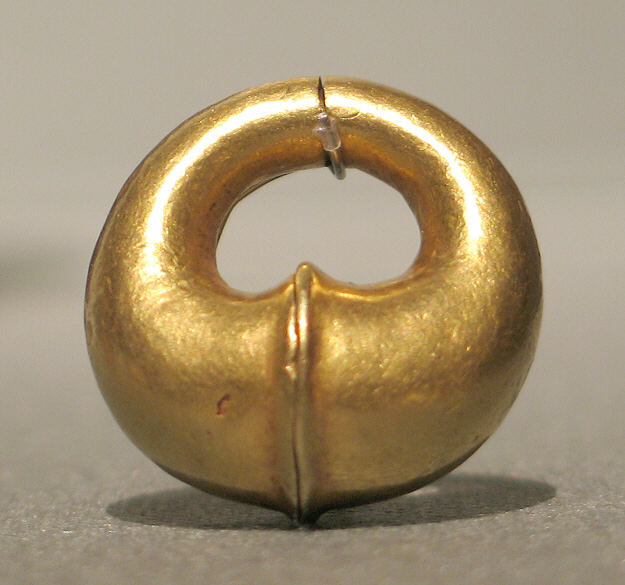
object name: earring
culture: indonesian, javanese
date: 701-833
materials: gold